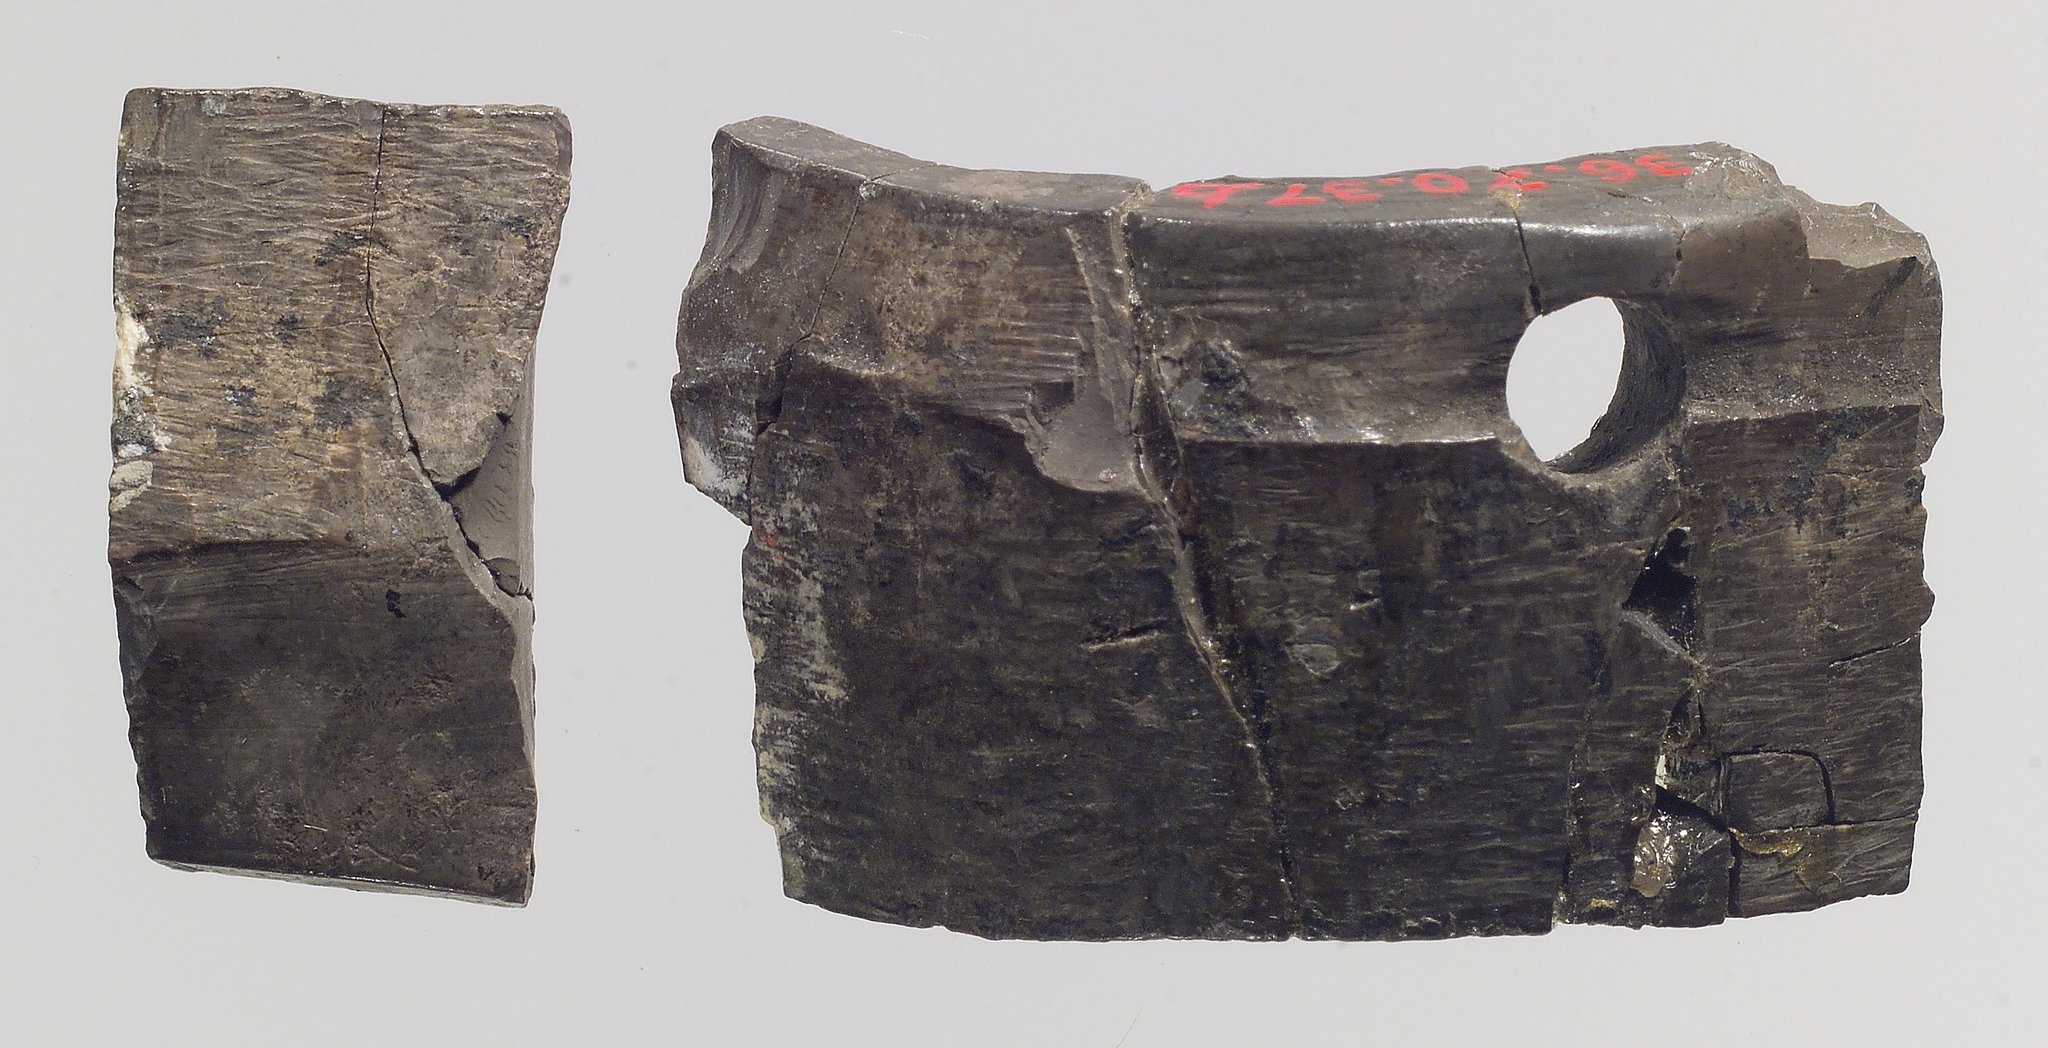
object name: furniture element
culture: assyrian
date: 1800-1701 BCE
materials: ivory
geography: anatolia